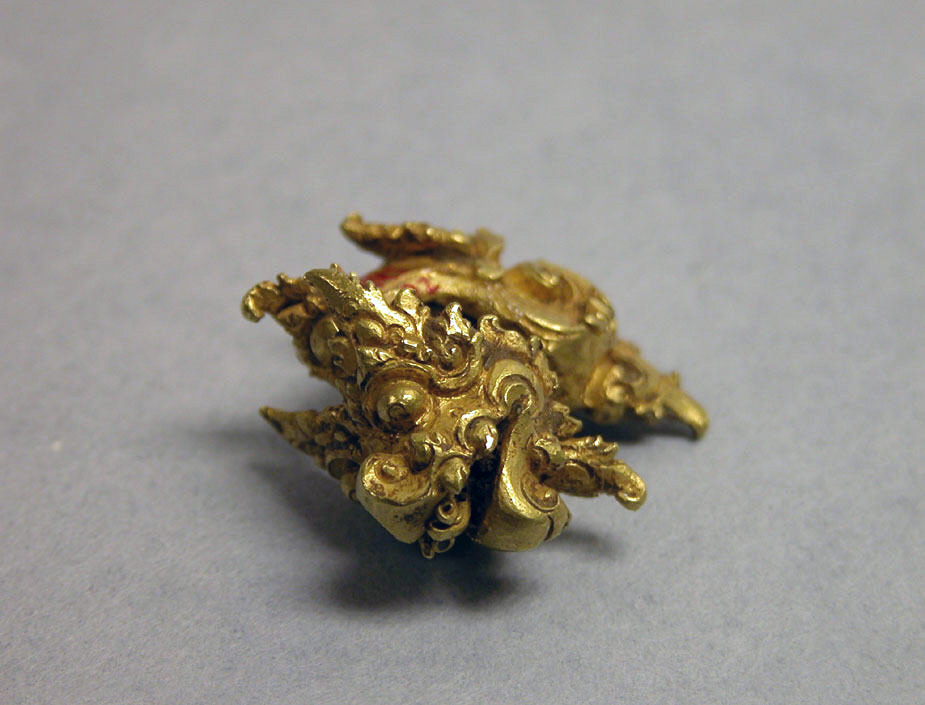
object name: ear ornament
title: Ear Ornament with Makara Motif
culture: indonesian, javanese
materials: gold